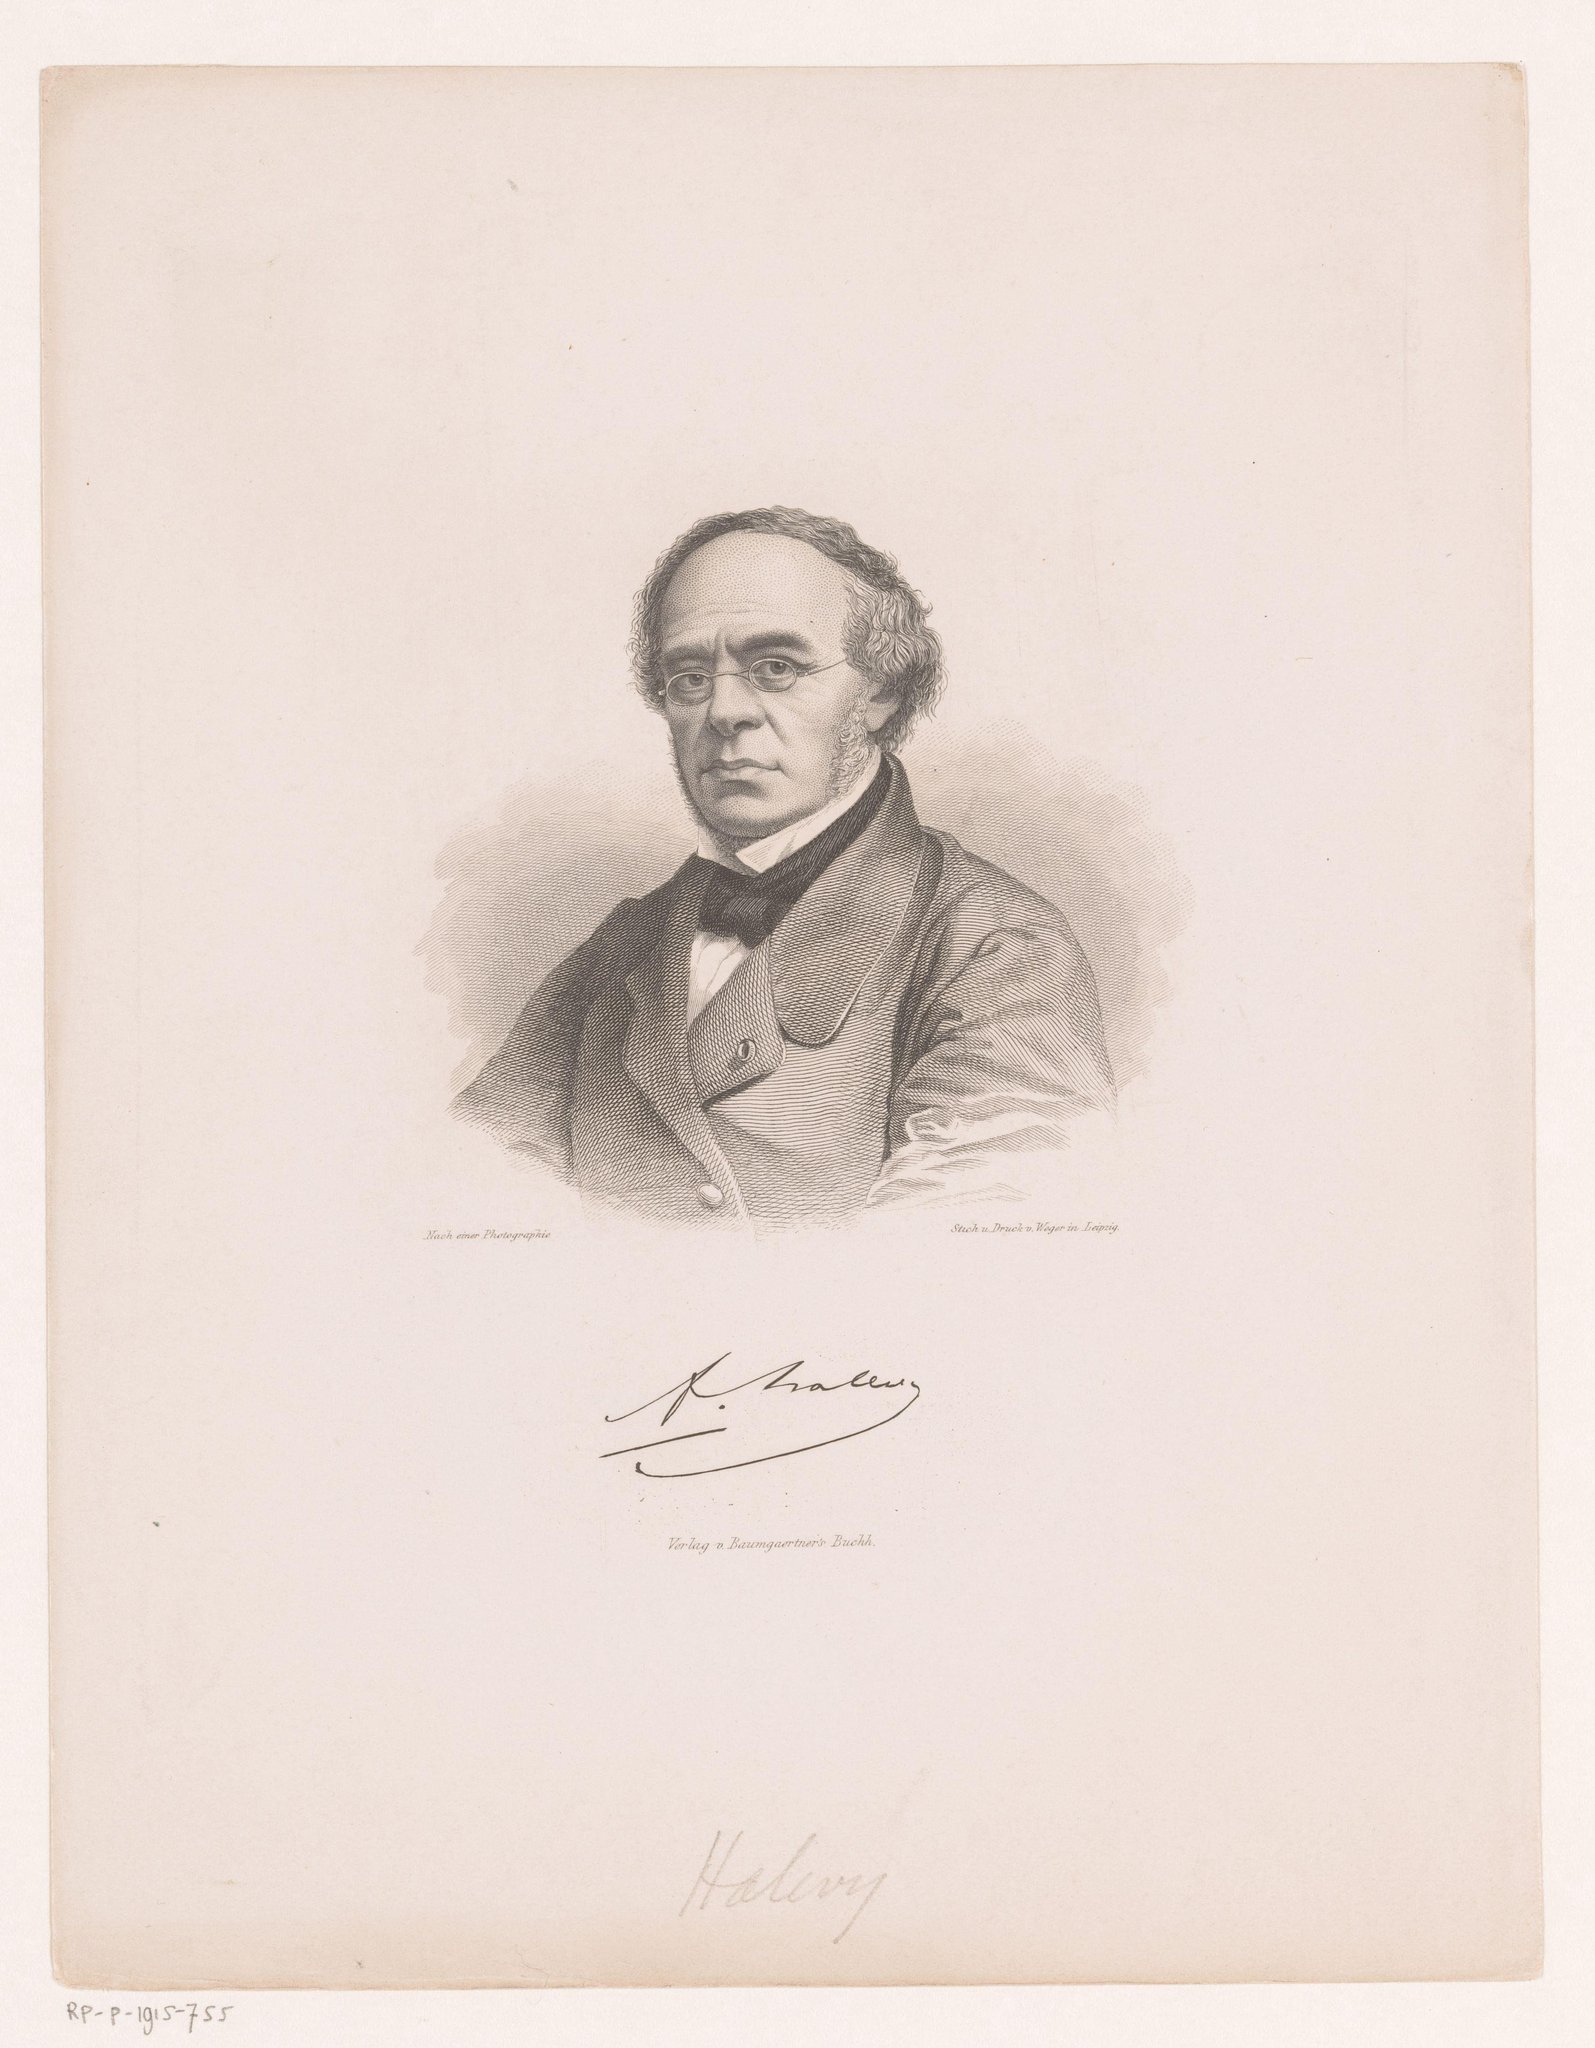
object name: print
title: Portret van Jacques Fromental Halévy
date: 1849-1892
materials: paper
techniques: engraving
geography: leipzig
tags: paris, historical persons, portrait of composer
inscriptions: collector's mark: Lugt 2228